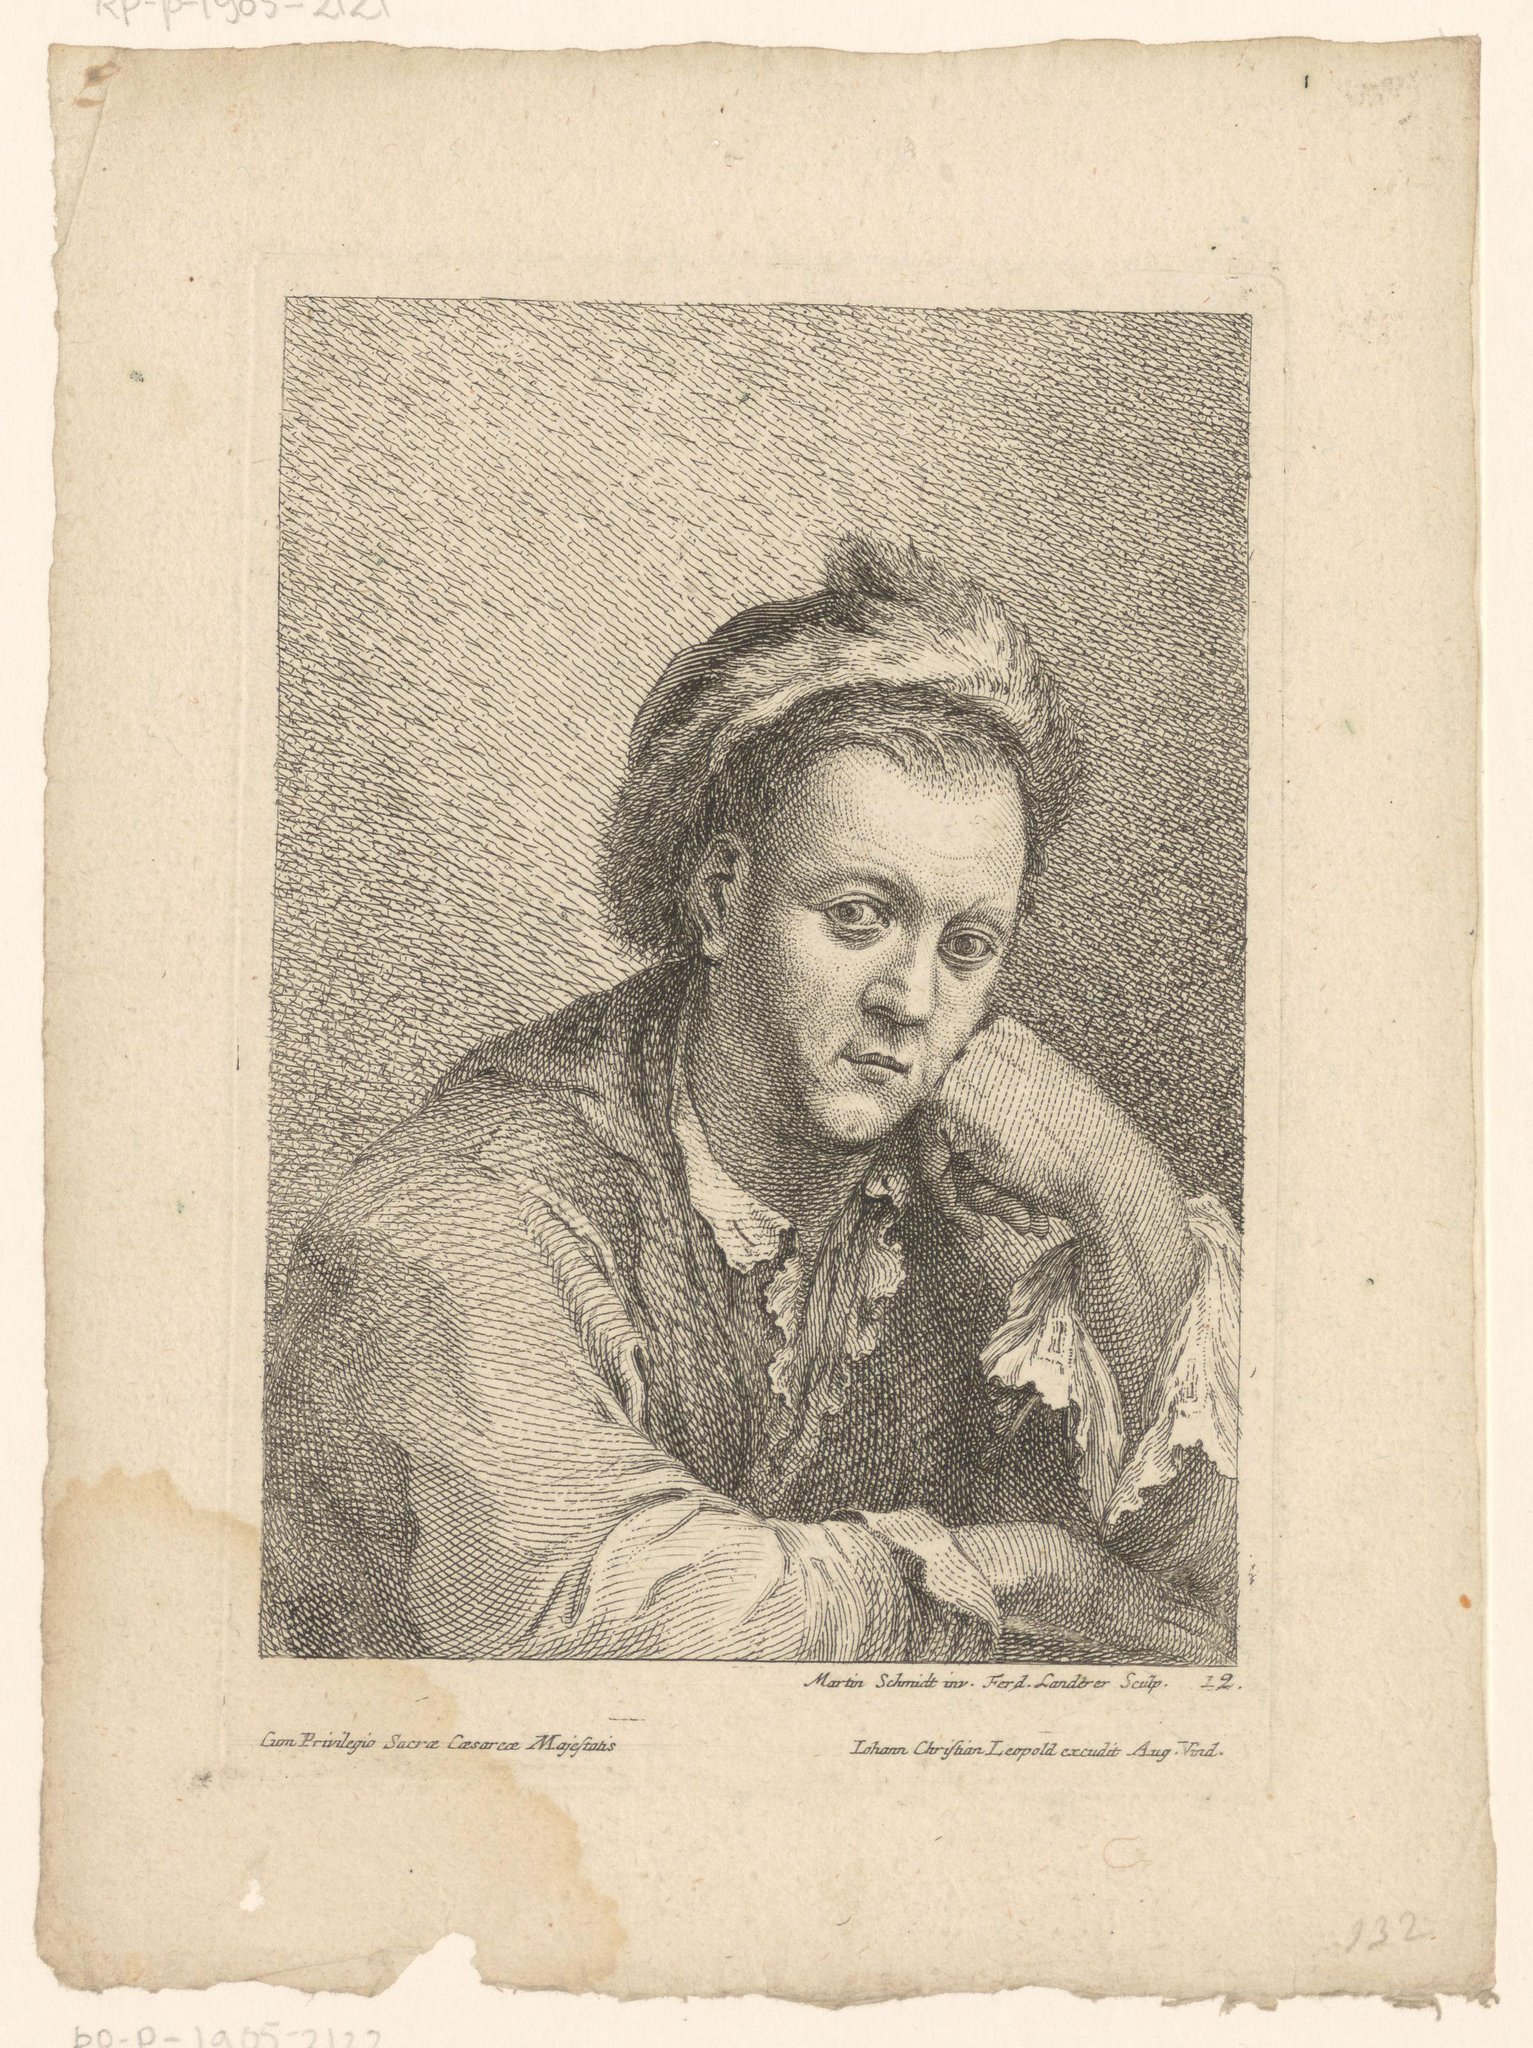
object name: print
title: Portret van een onbekende vrouw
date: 1760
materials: paper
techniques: etching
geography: augsburg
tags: anonymous historical person portrayed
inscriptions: number: ‘12’, collector's mark: Lugt 2228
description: Deze prent hoort bij een serie met in ieder geval elf prenten met portretten.